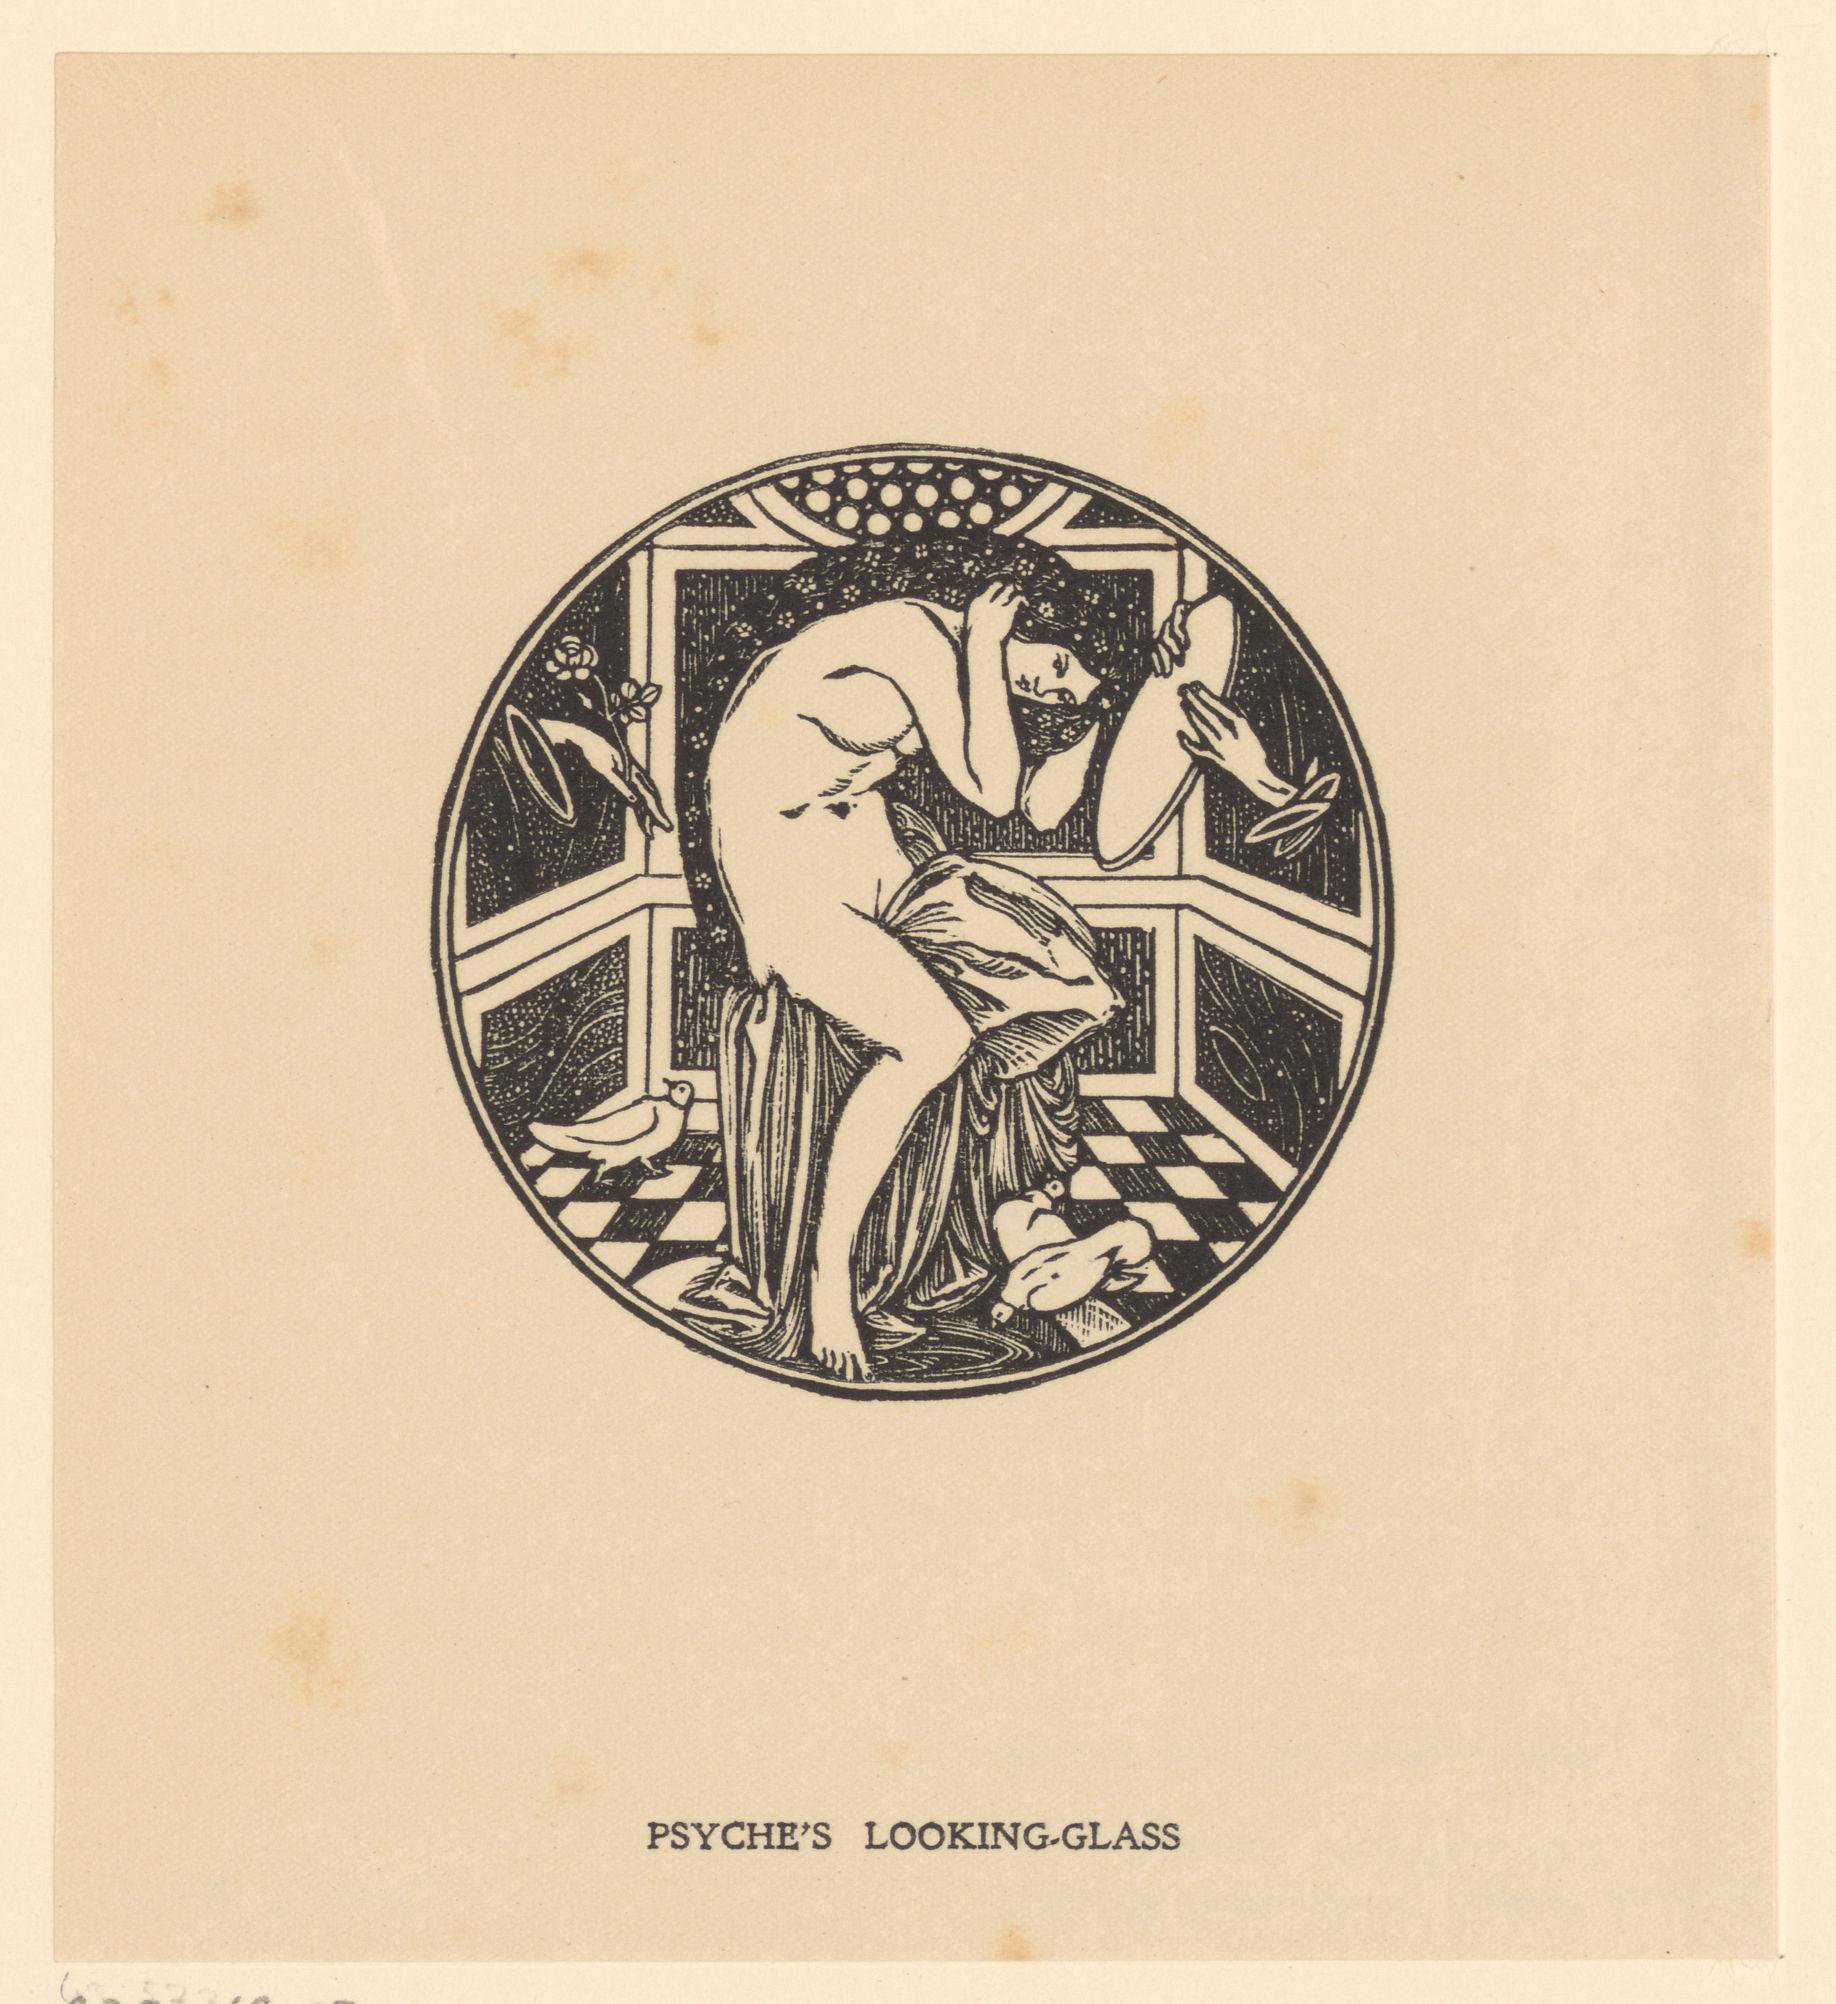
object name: print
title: Psyche kijkt in een spiegel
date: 1903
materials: paper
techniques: woodcut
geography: london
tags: psyche, mirror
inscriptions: collector's mark: Lugt 2228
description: Prent uit: The Venture 1 (1903). Prent ook gebruikt als illustratie in: The Marriage of Cupide and Psyches. Londen: Vale Press, 1897.